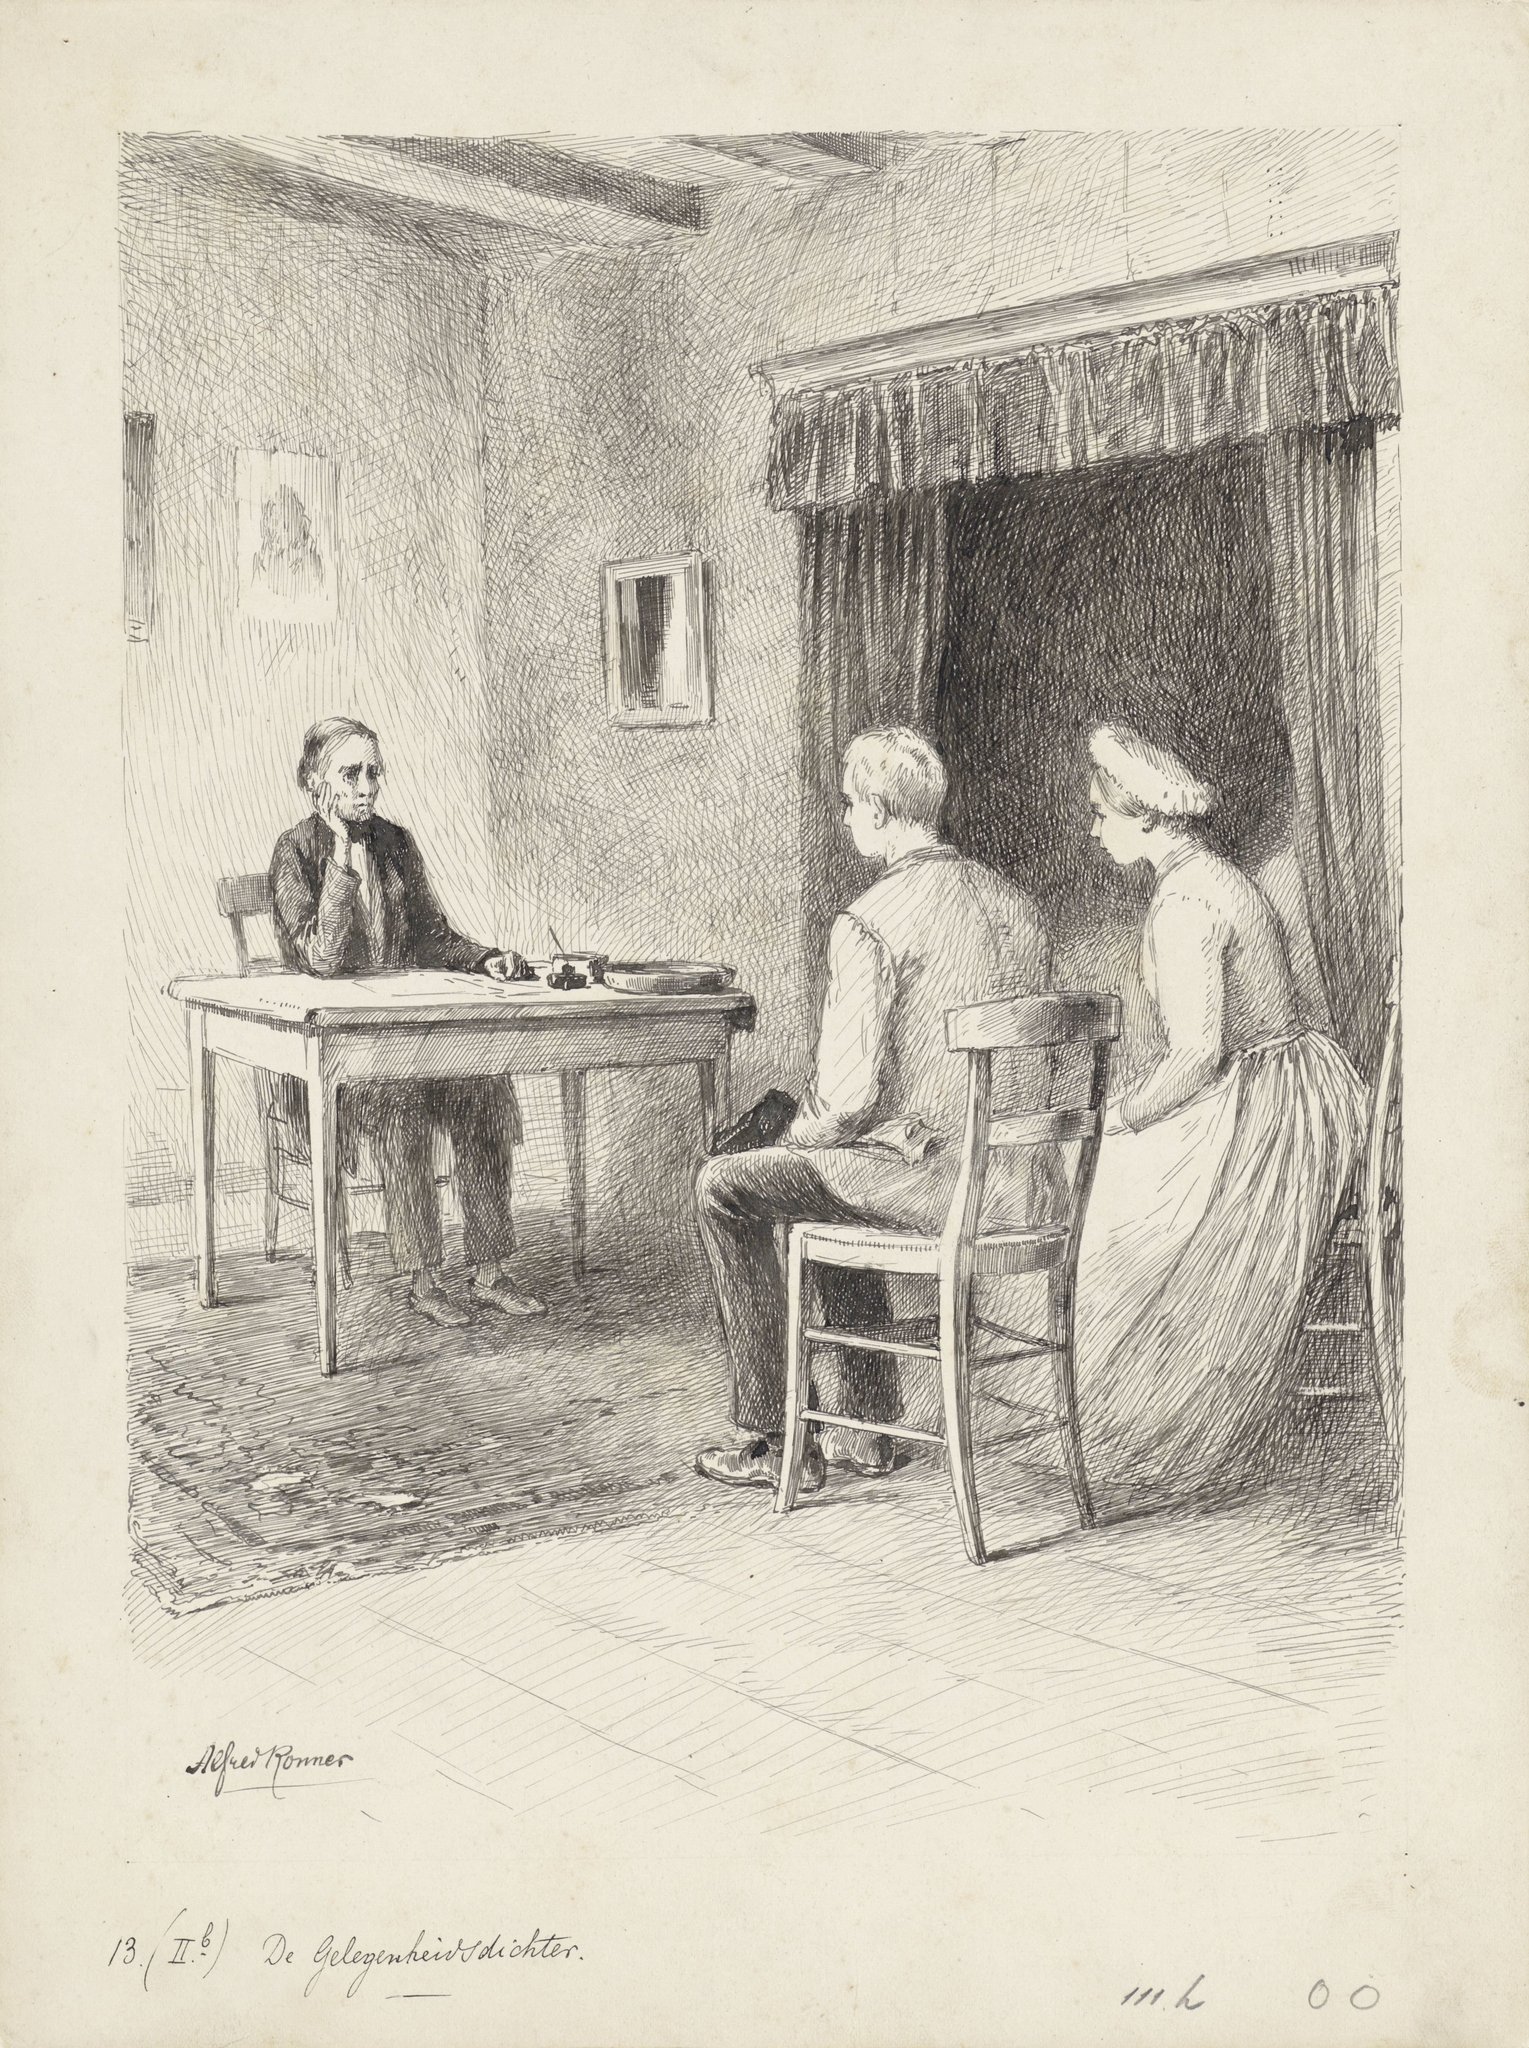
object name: drawing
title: De Gelegenheidsdichter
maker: alfred ronner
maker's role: draughtsman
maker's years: 1852-1901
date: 1893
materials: ink, paper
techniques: pen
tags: (reiger, a.f.j., vluchtige schetsen uit het volksleven) specific works of literature (with author, title), writer, poet, author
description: Illustratie voor 'Vluchtige Schetsen uit het Volksleven' door A.F.J. Reiger. Ontwerp voor een prent.